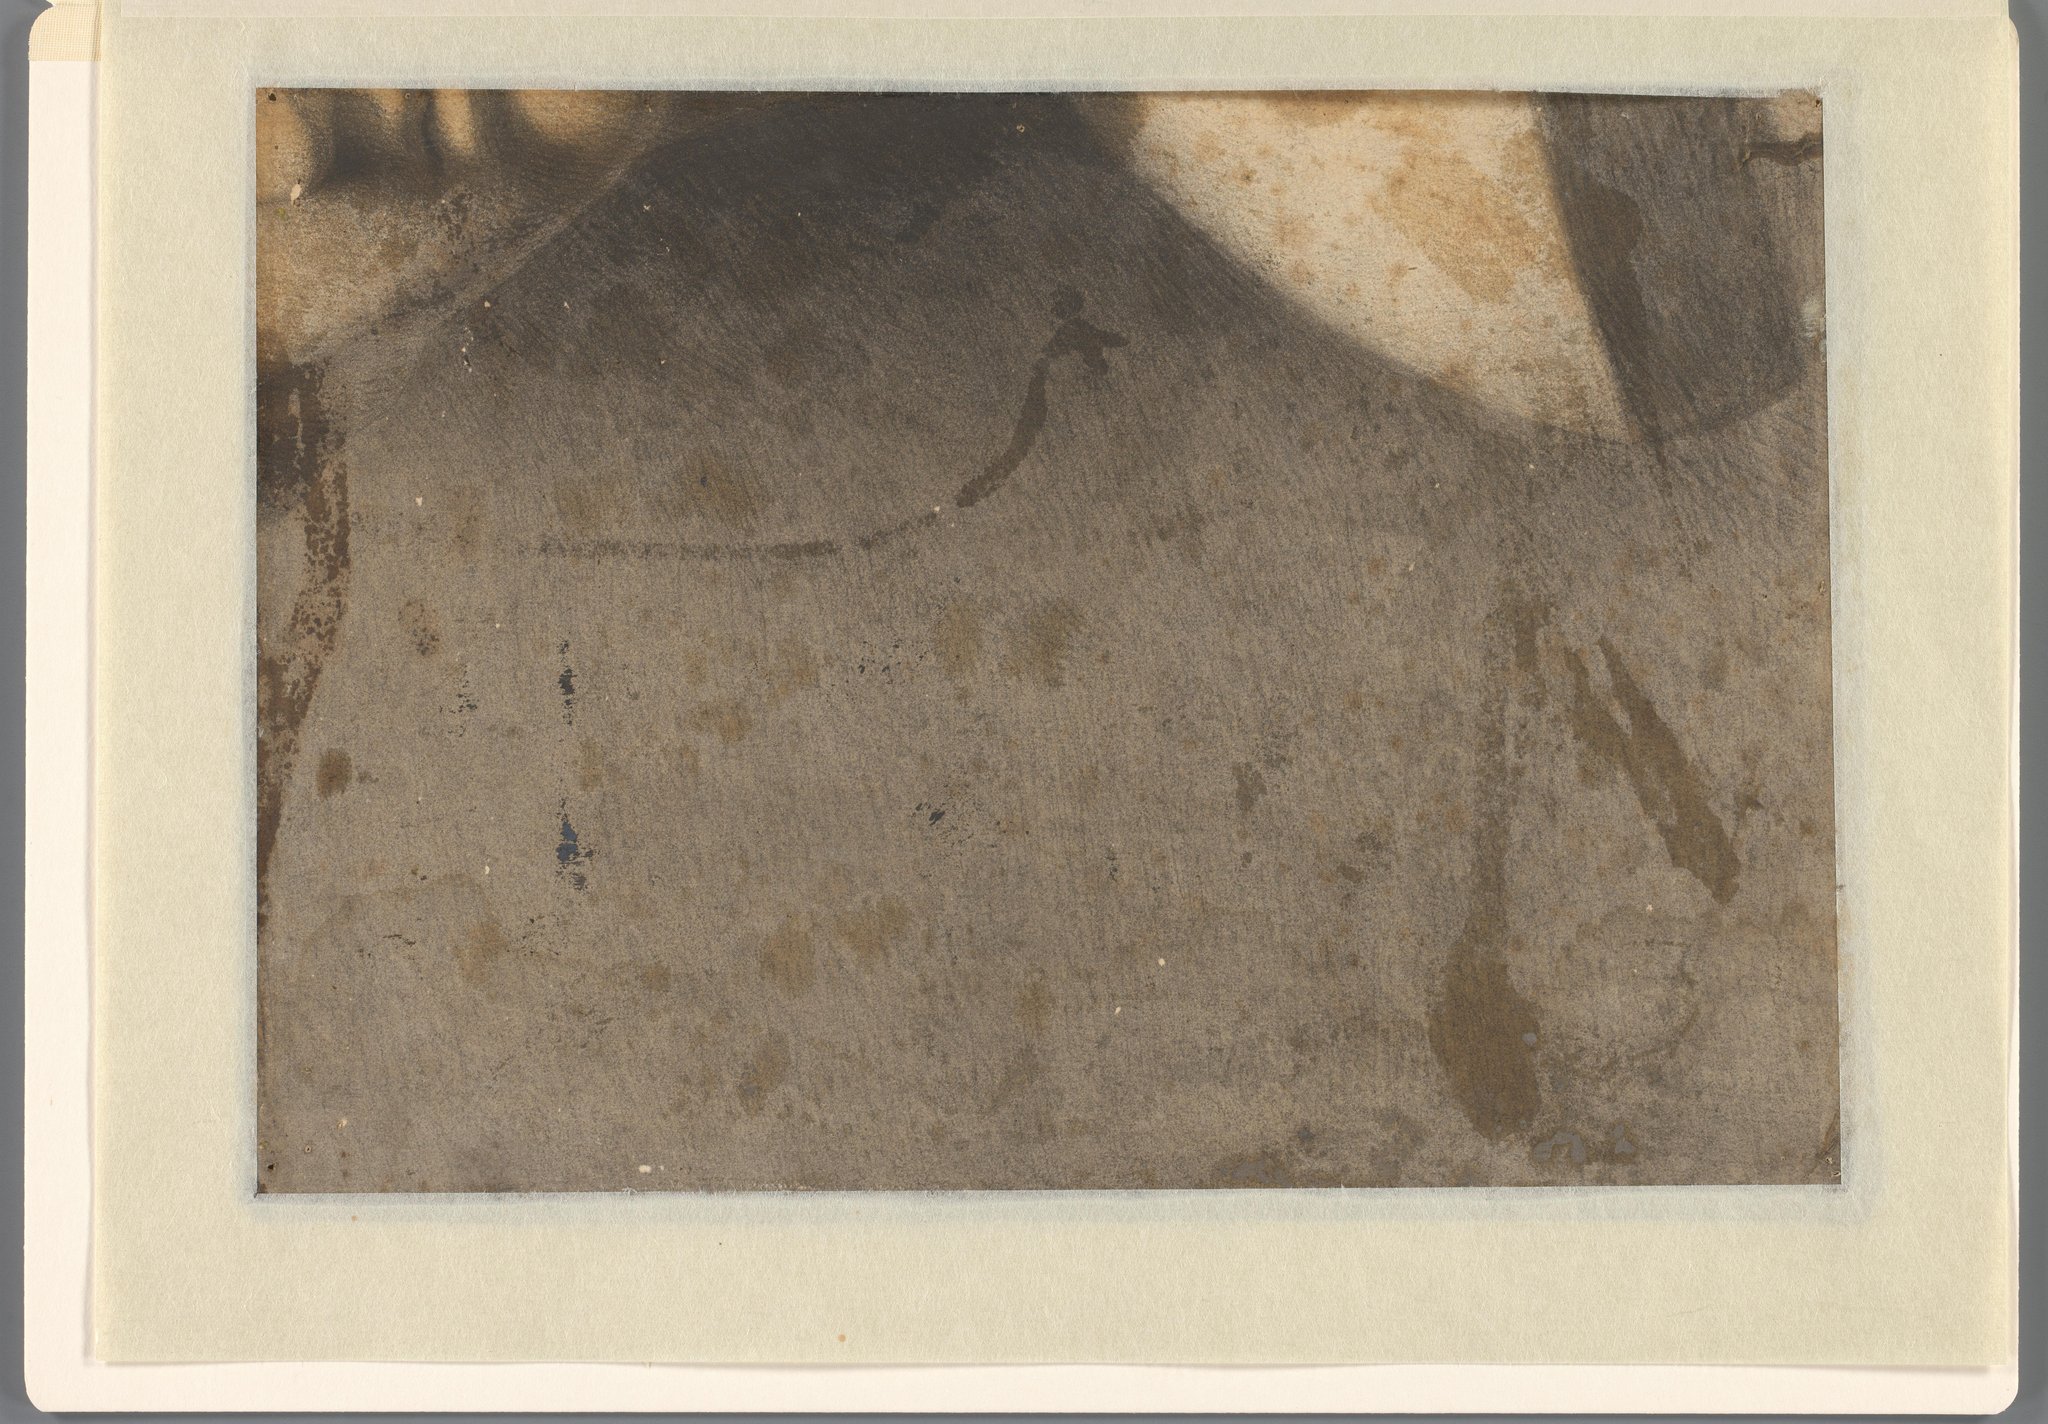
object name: drawing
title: Fragment van een grotere tekening van een persoon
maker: jan weissenbruch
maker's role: painter, print maker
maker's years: 1822-1880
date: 1832-1880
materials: chalk, paper